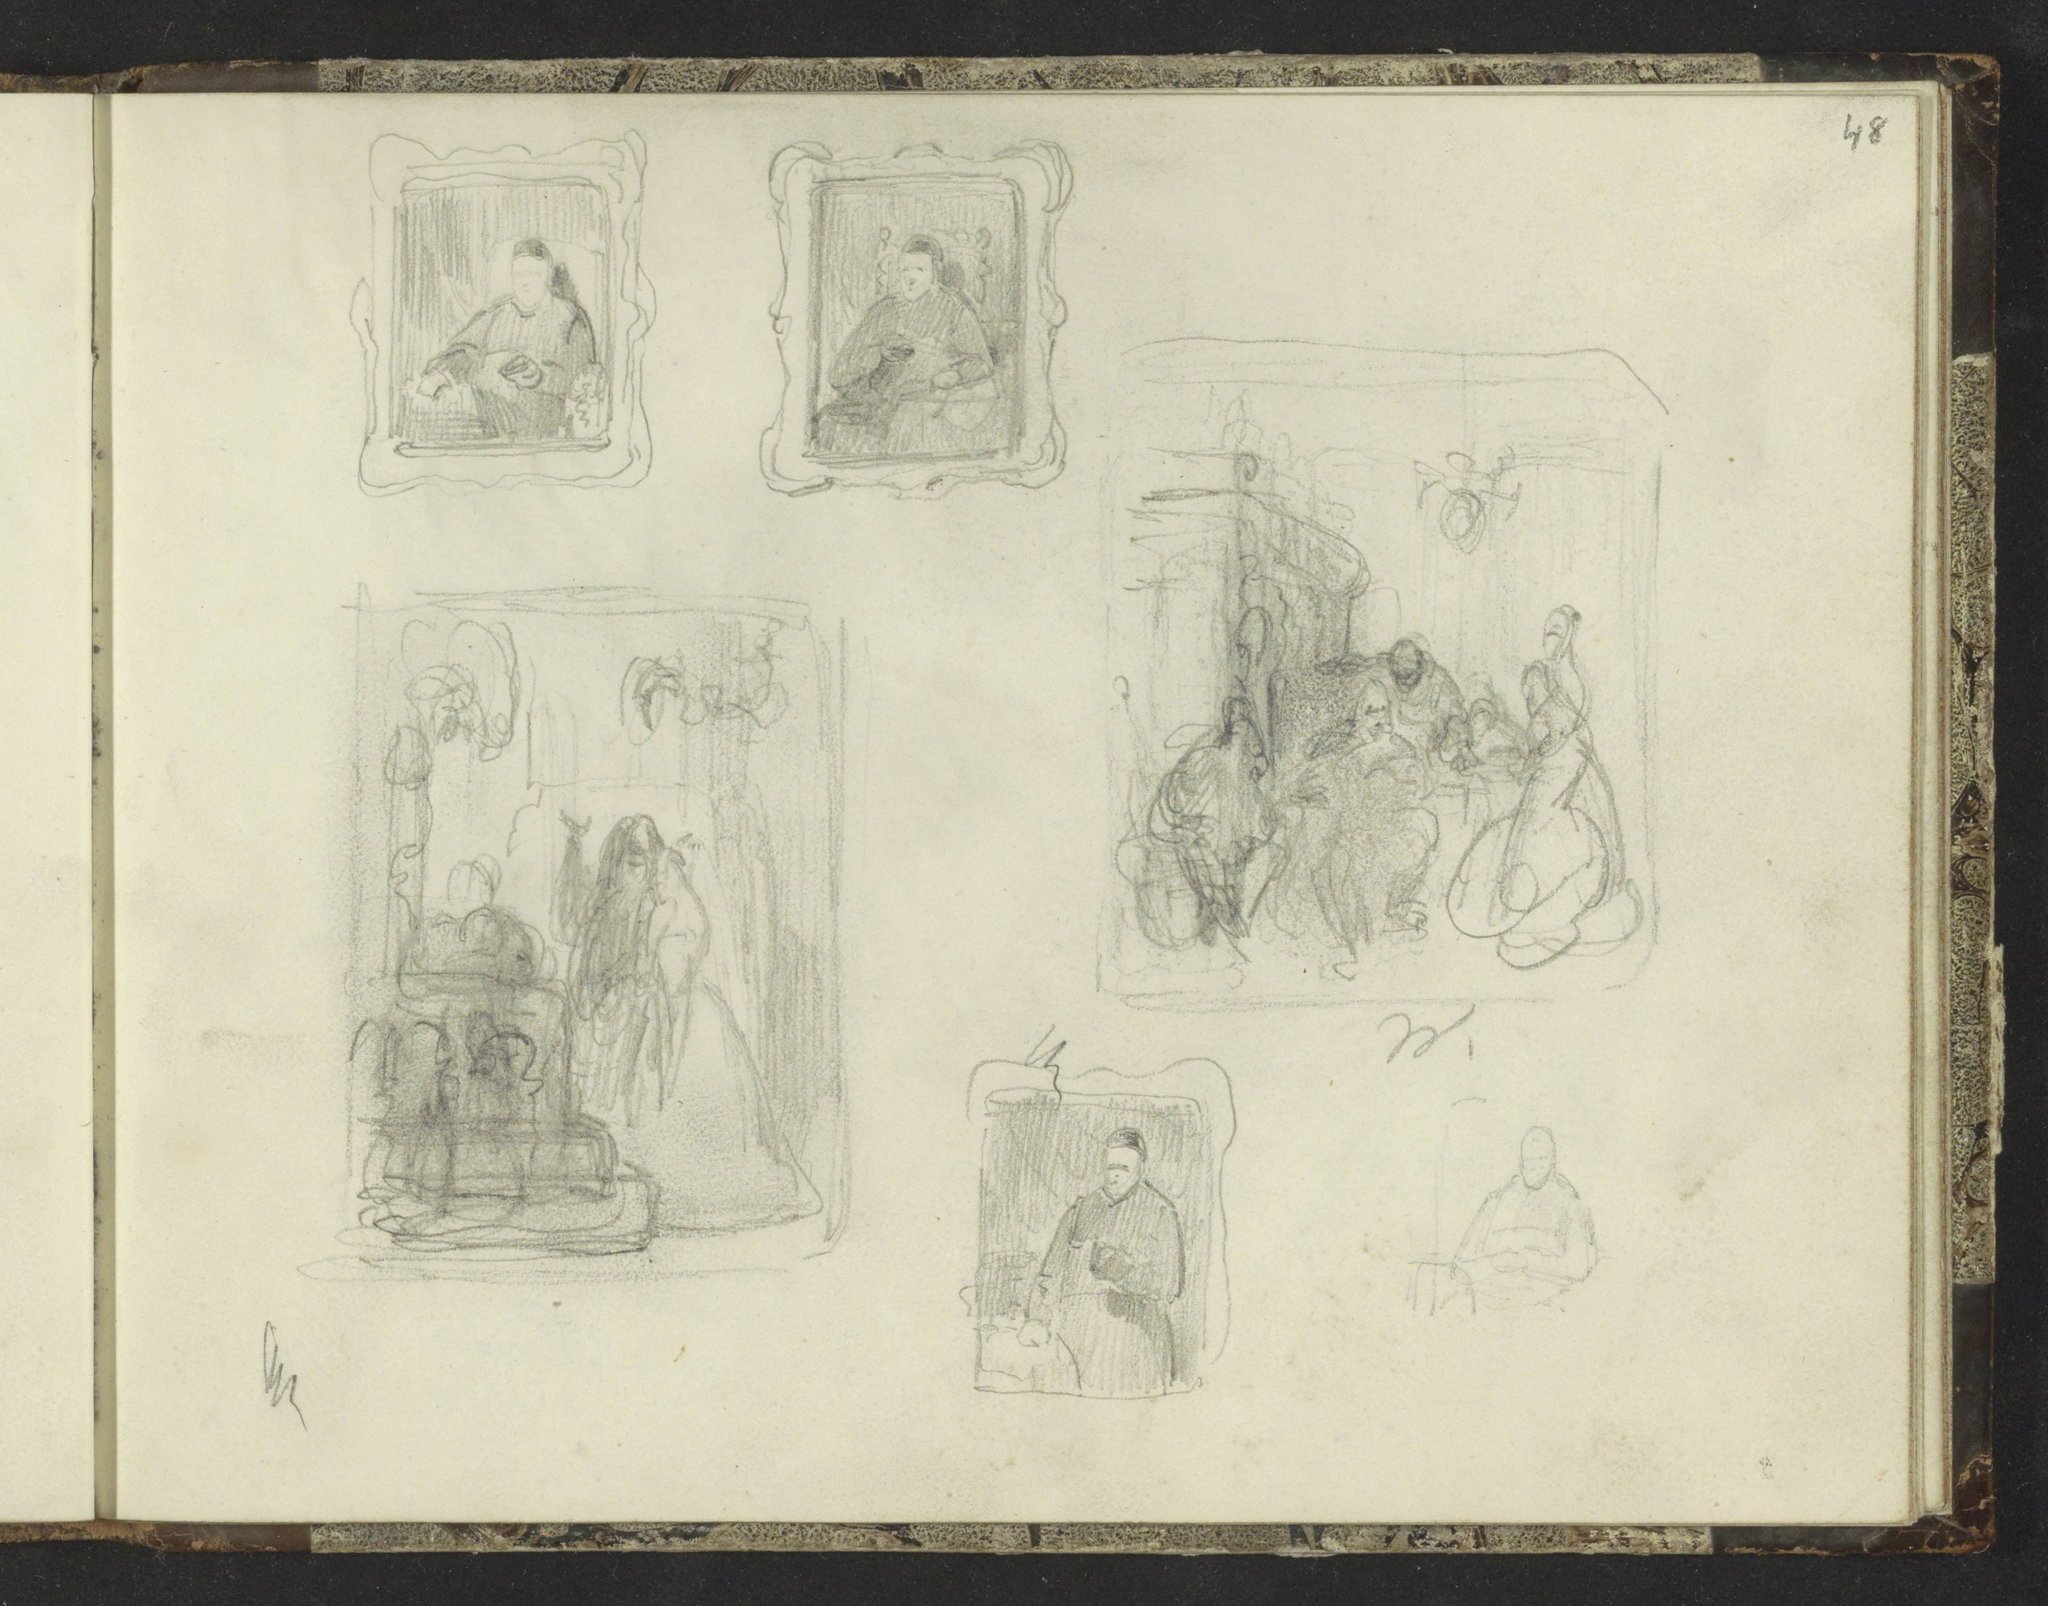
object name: sketchbook leaf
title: Portretten in lijsten en interieurs met figuren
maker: willem hendrik schmidt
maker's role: draughtsman, painter, print maker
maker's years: 1809-1849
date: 1819-1849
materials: paper, pencil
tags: anonymous historical person portrayed, interior of the house, frame of painting, etc.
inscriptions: annotation: ‘W.’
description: Tekeningen in kaders of lijsten. Vermoedelijk voorstudies of kopieën naar schilderijen. Blad 48 recto uit een schetsboek met 58 bladen.